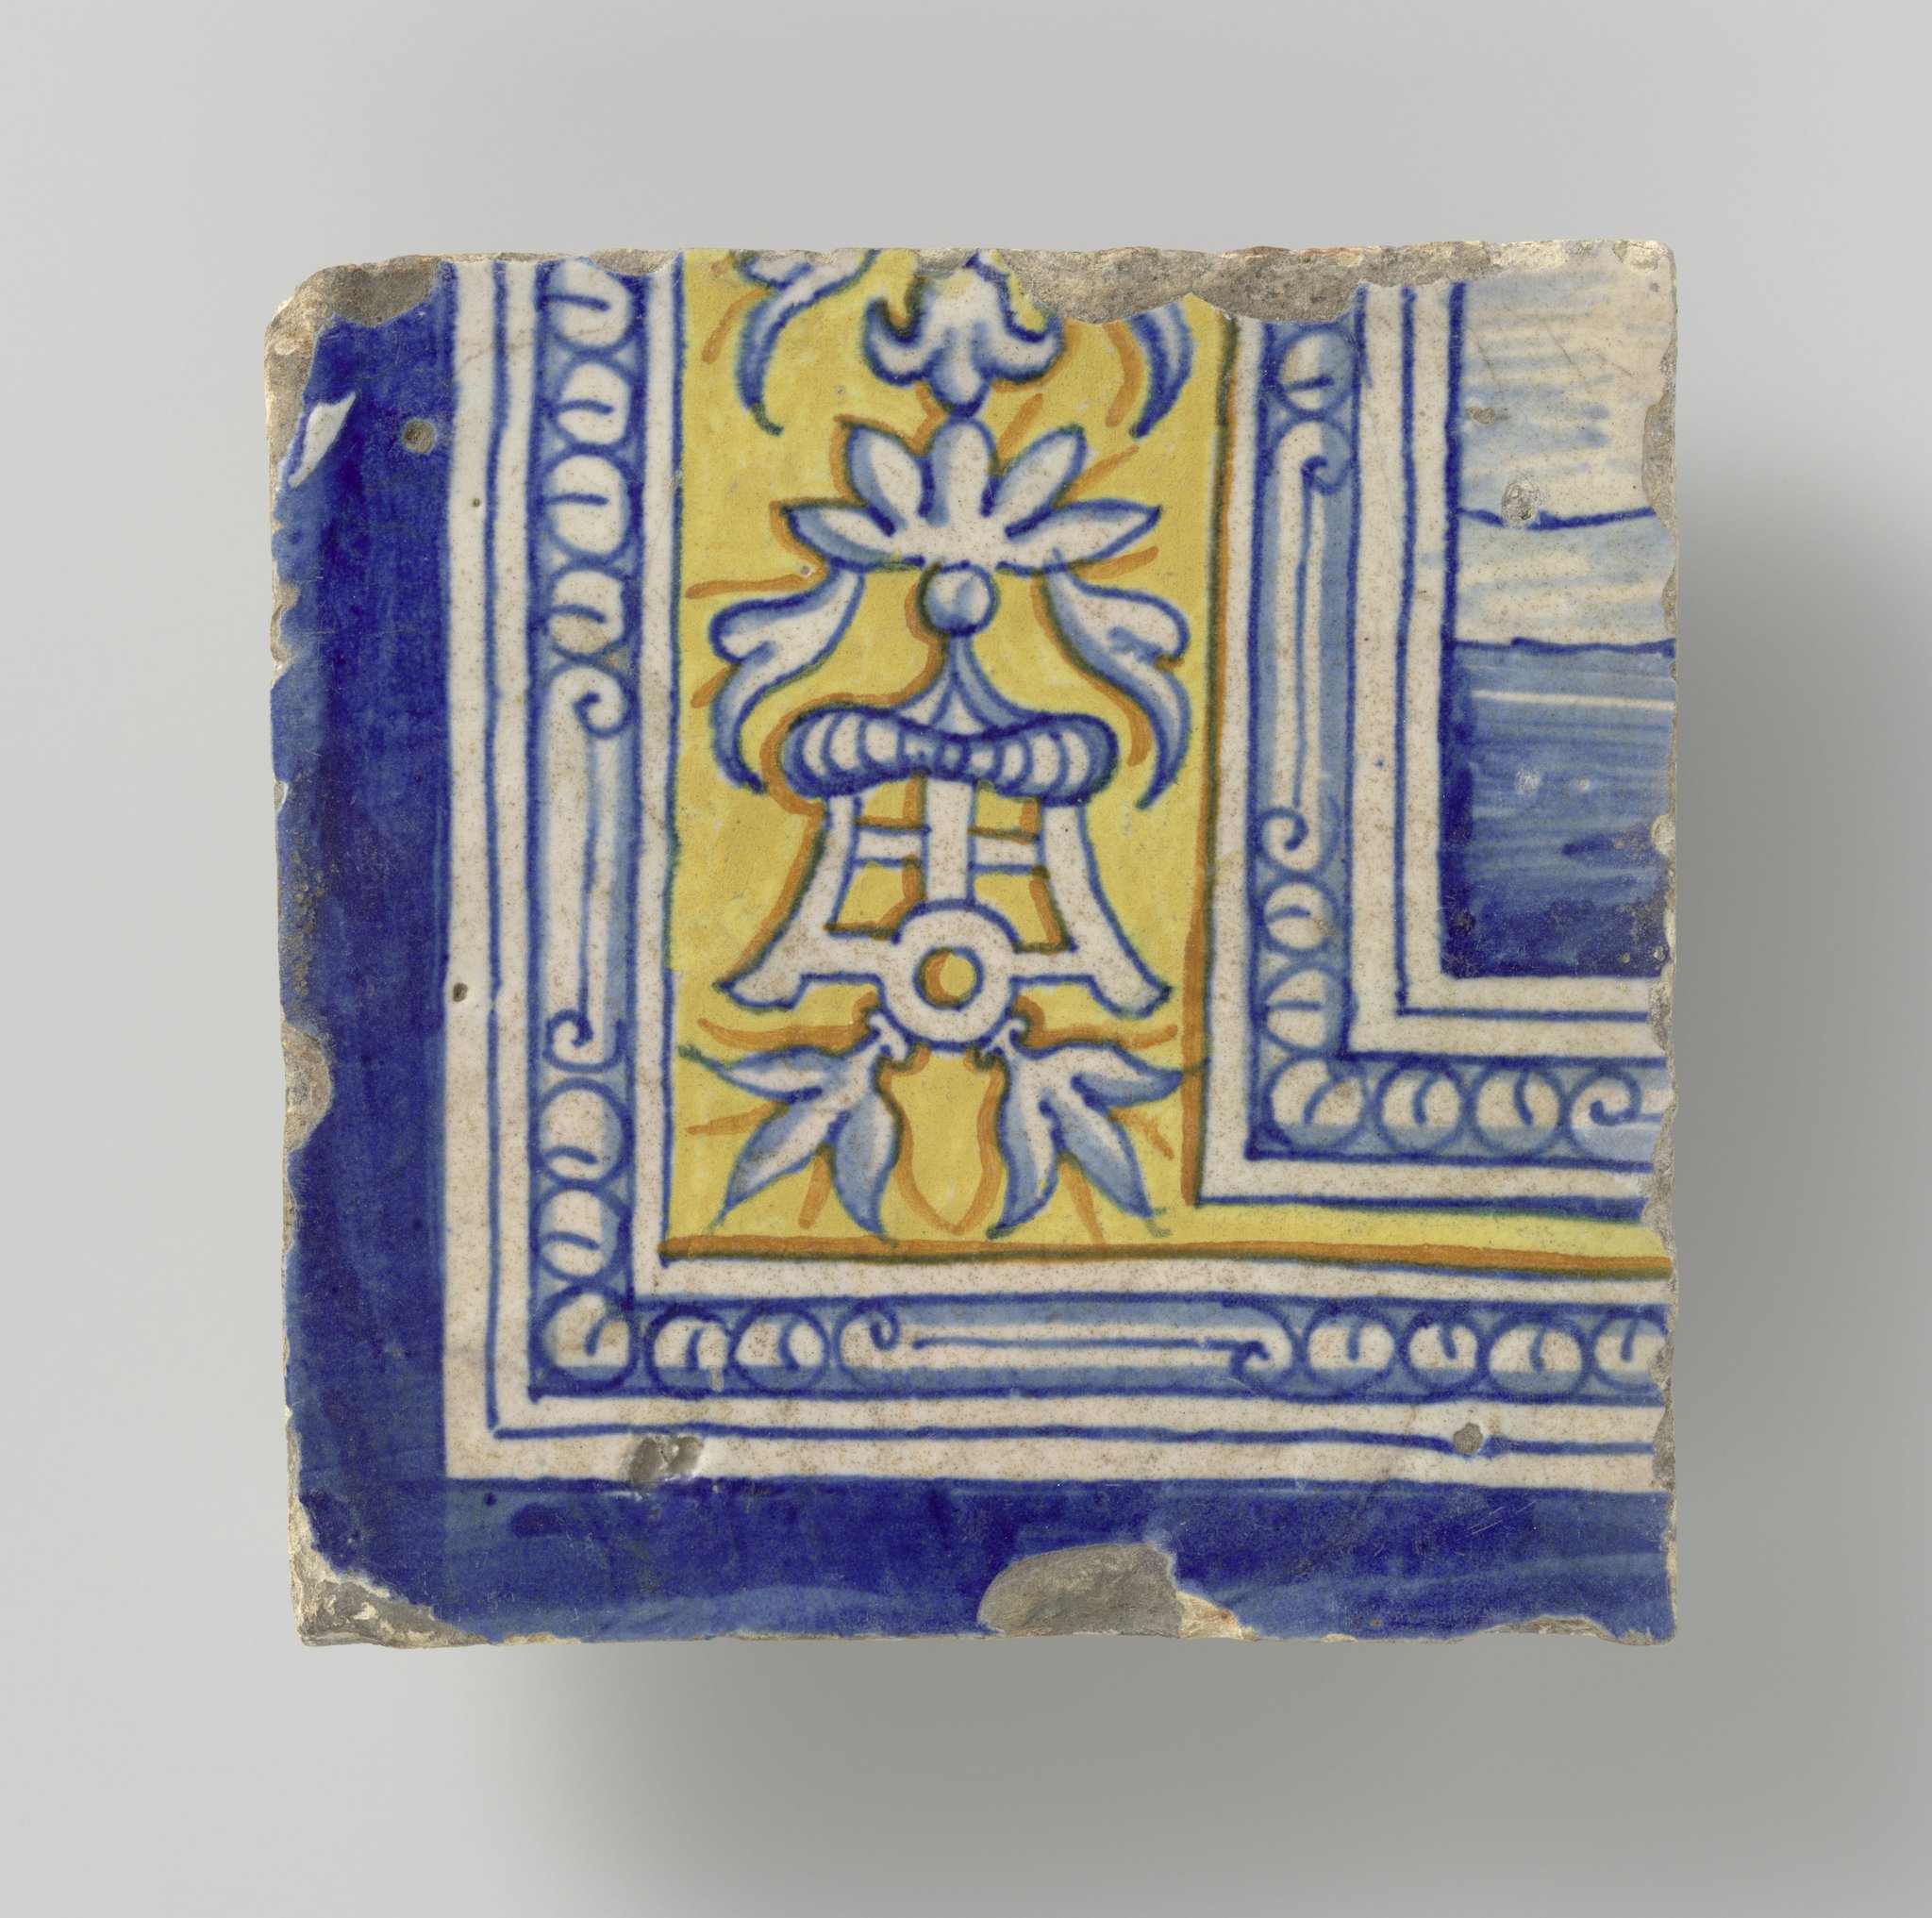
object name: tile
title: Randtegel van een tegeltableau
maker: Anonymous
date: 1550-1600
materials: earthenware, glaze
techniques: maiolica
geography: antwerp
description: Randtegel voor een hoek van een tegeltableau, beschilderd in blauw, groen, geel en oranje met rolwerk-motieven tussen een parellijst.